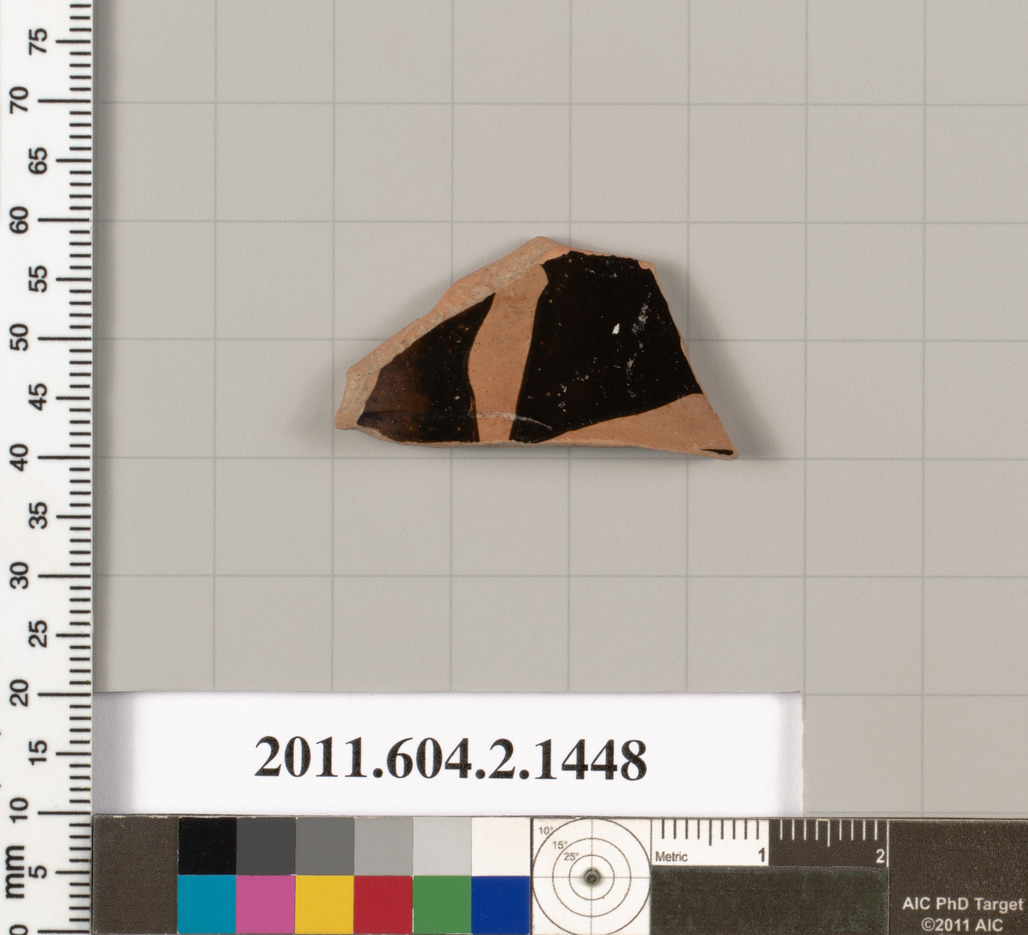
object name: skyphos fragment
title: Terracotta fragment of a skyphos (deep drinking cup)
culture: greek, attic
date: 475-451 BCE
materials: terracotta